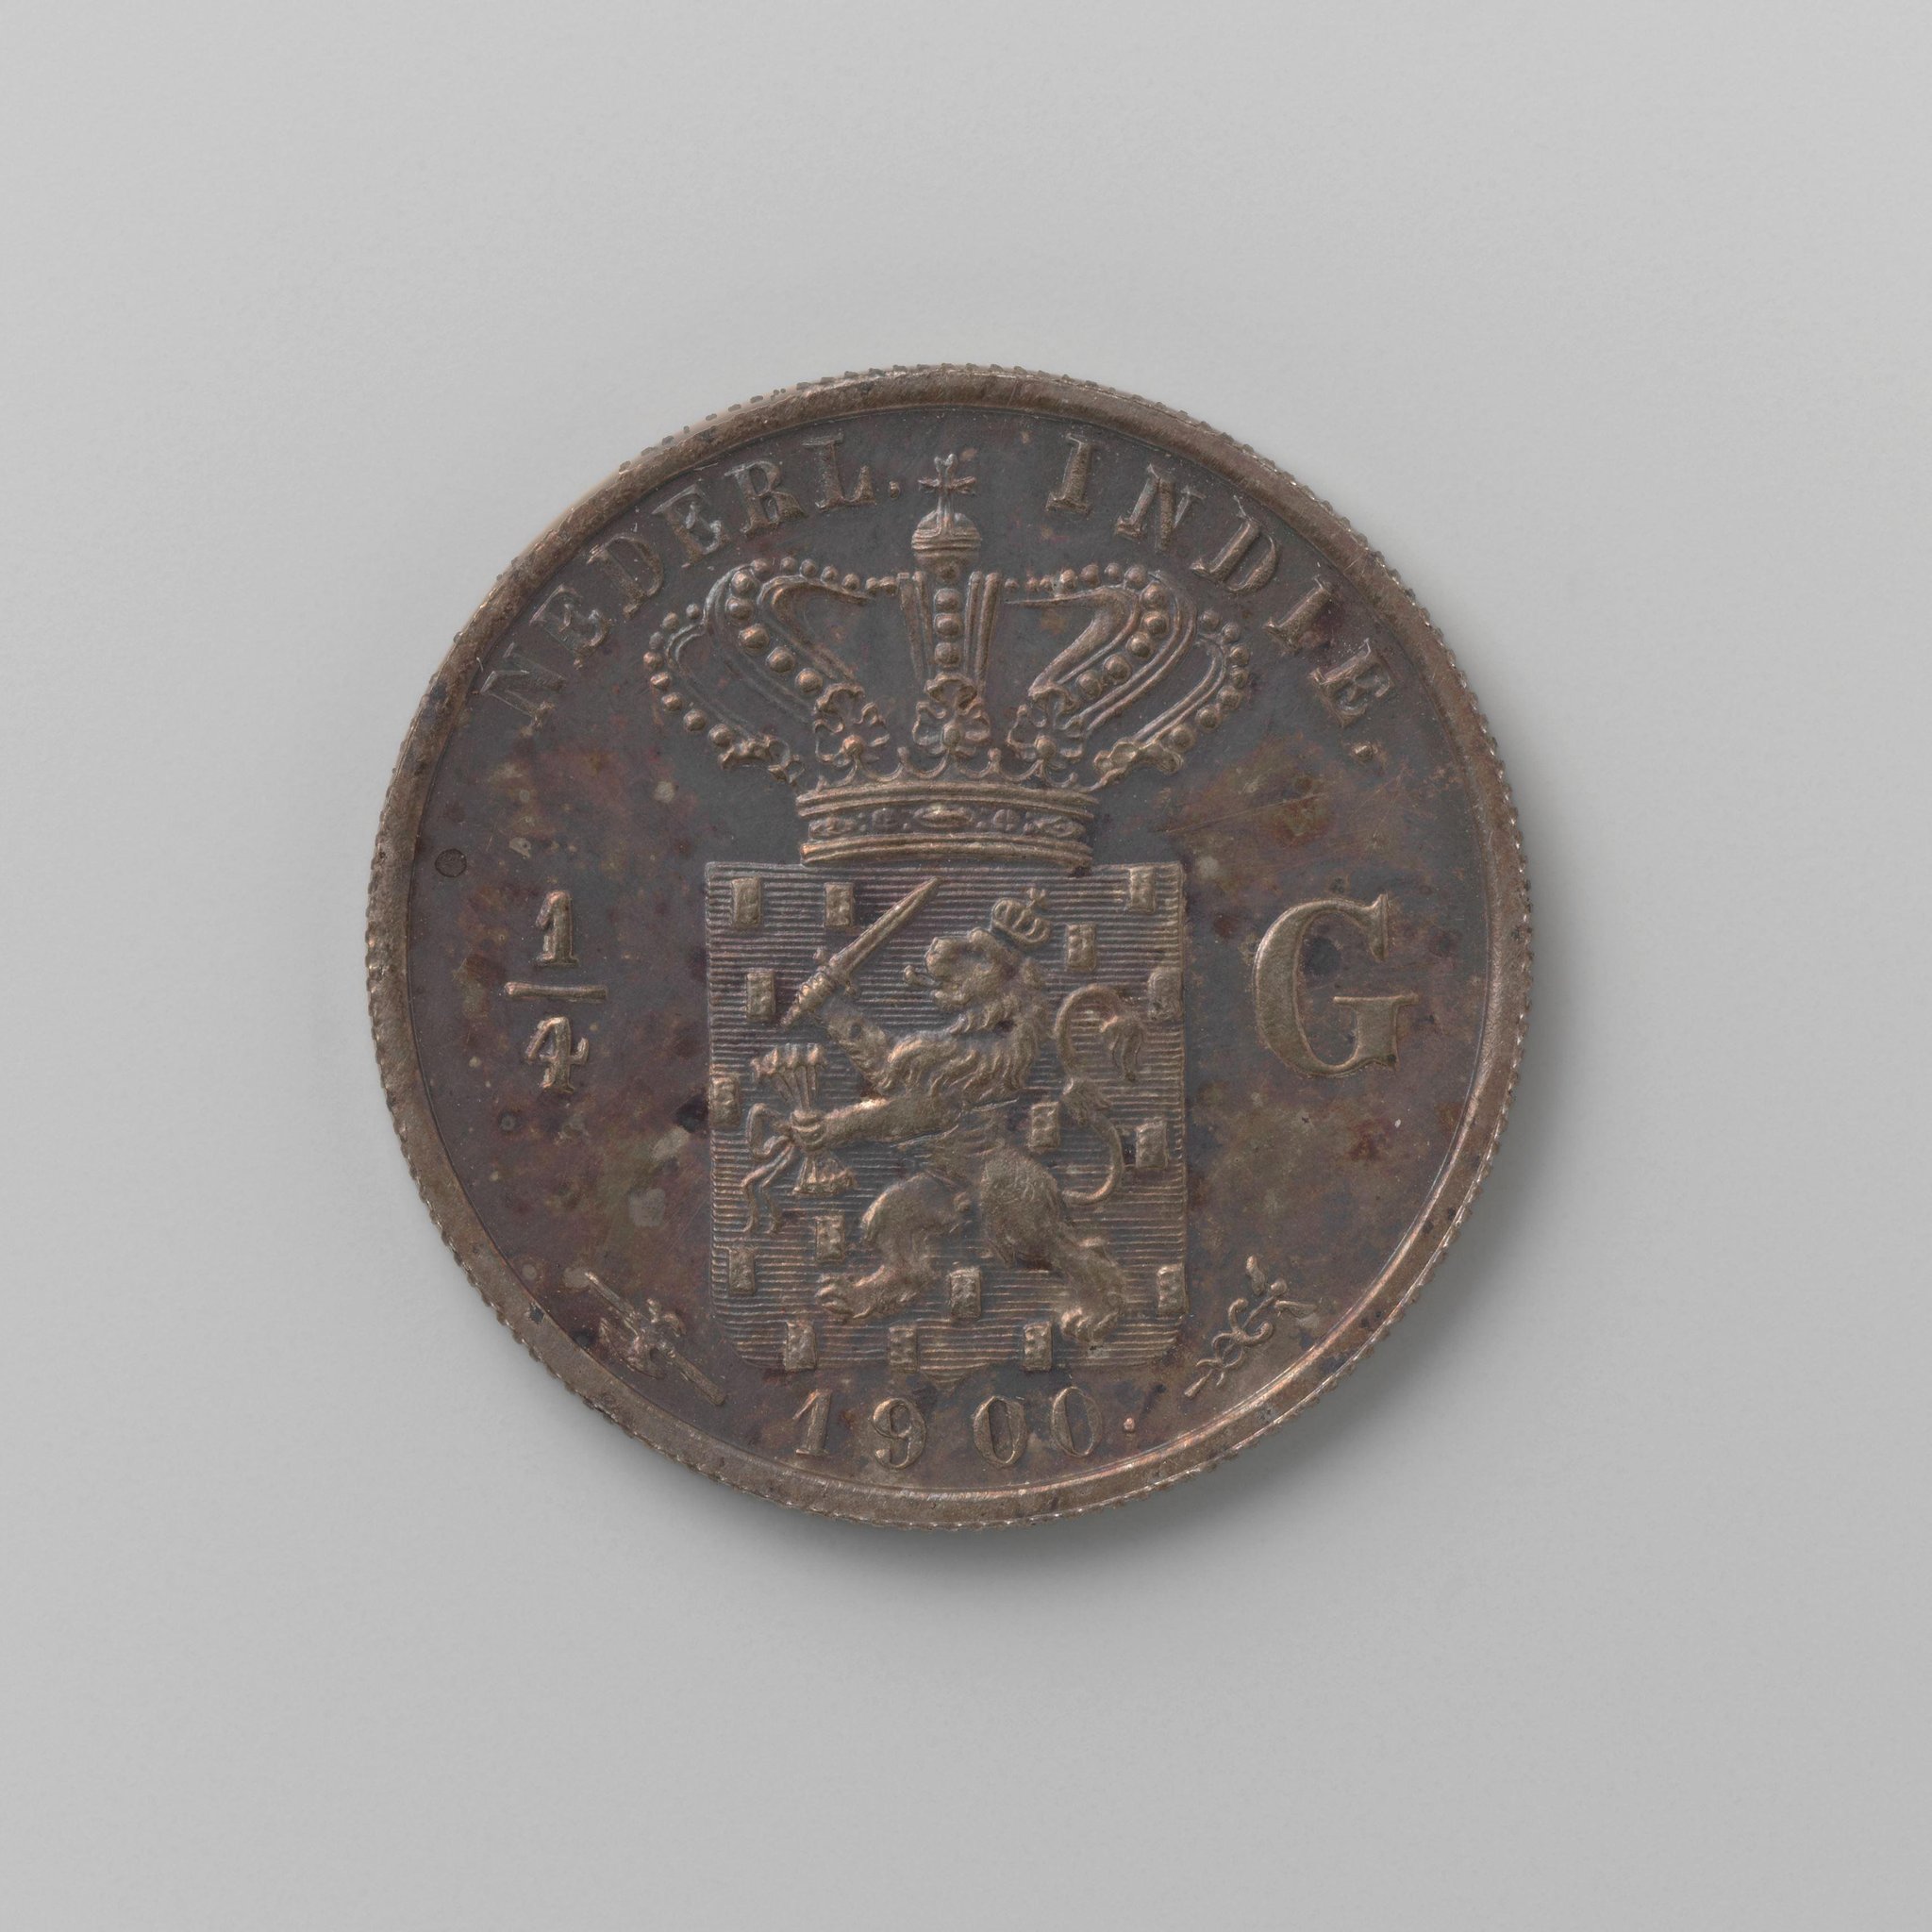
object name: coin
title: Nederlands Indië,1/4 gulden,1900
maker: wilhelmina of the netherlands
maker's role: print maker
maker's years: 1880-1962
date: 1900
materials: silver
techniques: striking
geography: utrecht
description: Zilveren munt. Voorzijde: tussen waarde-aanduiding 1/4 G gekroond rijkswapenschild. Boven kroon landsaanduiding en onder wapenschild jaartal. Keerzijde: drieregelig Maleis opschrift in Arabische tekens, waaromheen tussen zeven uitschietende stralen omschrift in het Javaans. Kartelrand.